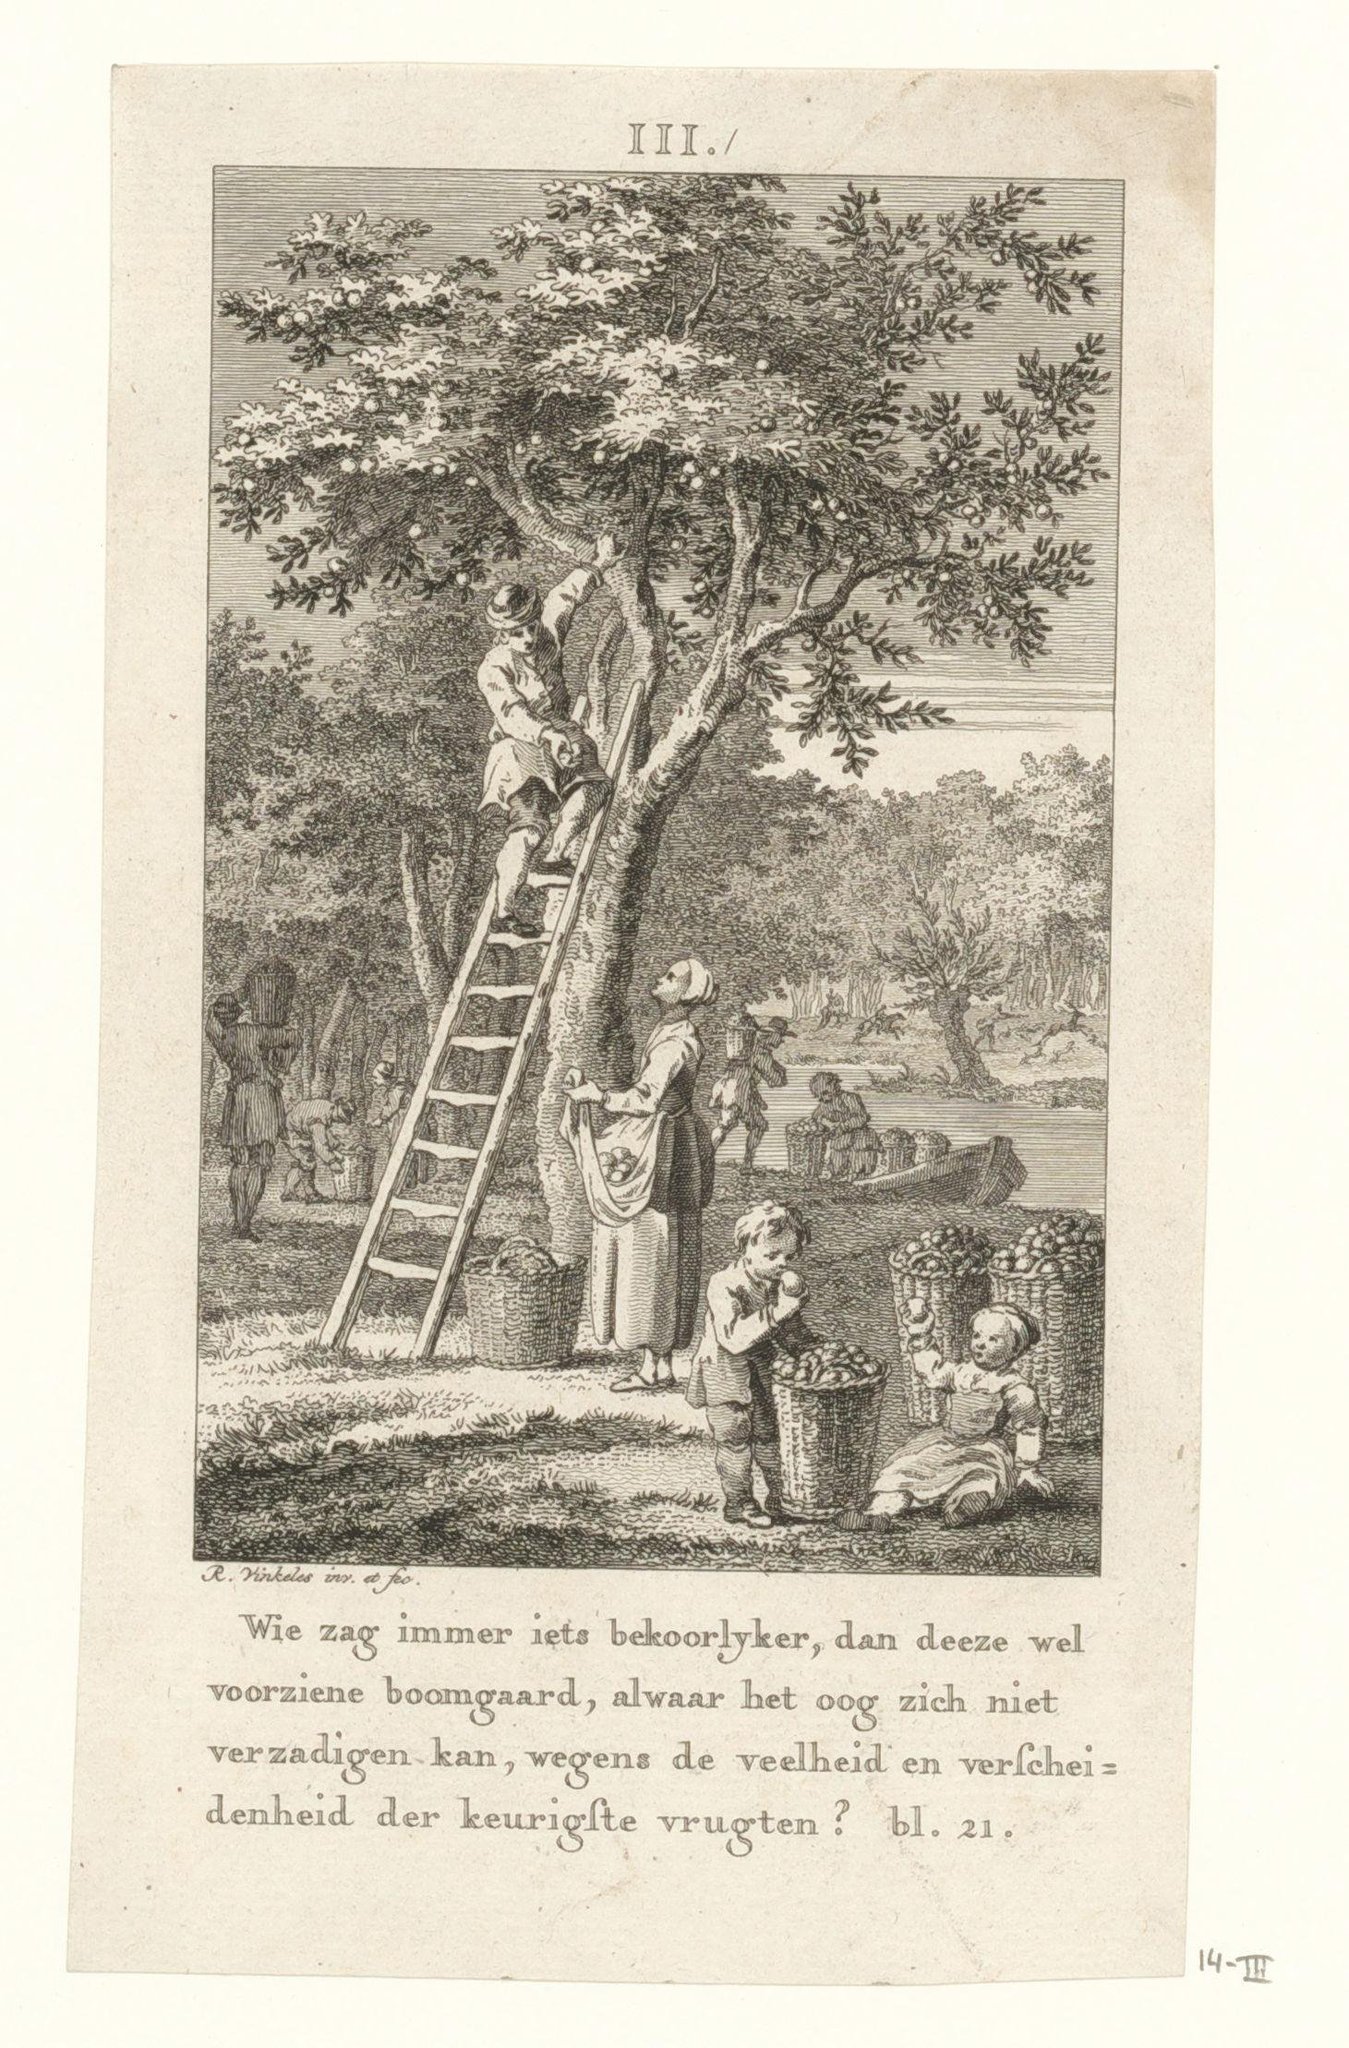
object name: print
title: Appeloogst in de herfst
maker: reinier vinkeles (i)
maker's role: draughtsman, print maker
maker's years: 1741-1816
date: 1768-1769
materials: paper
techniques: etching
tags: year divided into four seasons, fruits: apple, reaping, picking, mowing ~ harvest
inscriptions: stamp, collector's mark: Lugt 1641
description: Prent waarschijnlijk uit: Engelberts, Engelbertus Matthias. Proeve van bespiegelingen in de Lente (...). Amsterdam: Yntema & Tieboel, 1768, dl. 1. Of uit: Engelberts, Engelbertus Matthias. Bespiegelingen over de Vier Getyden des Jaars. Amsterdam: Yntema & Tieboel, 1769.